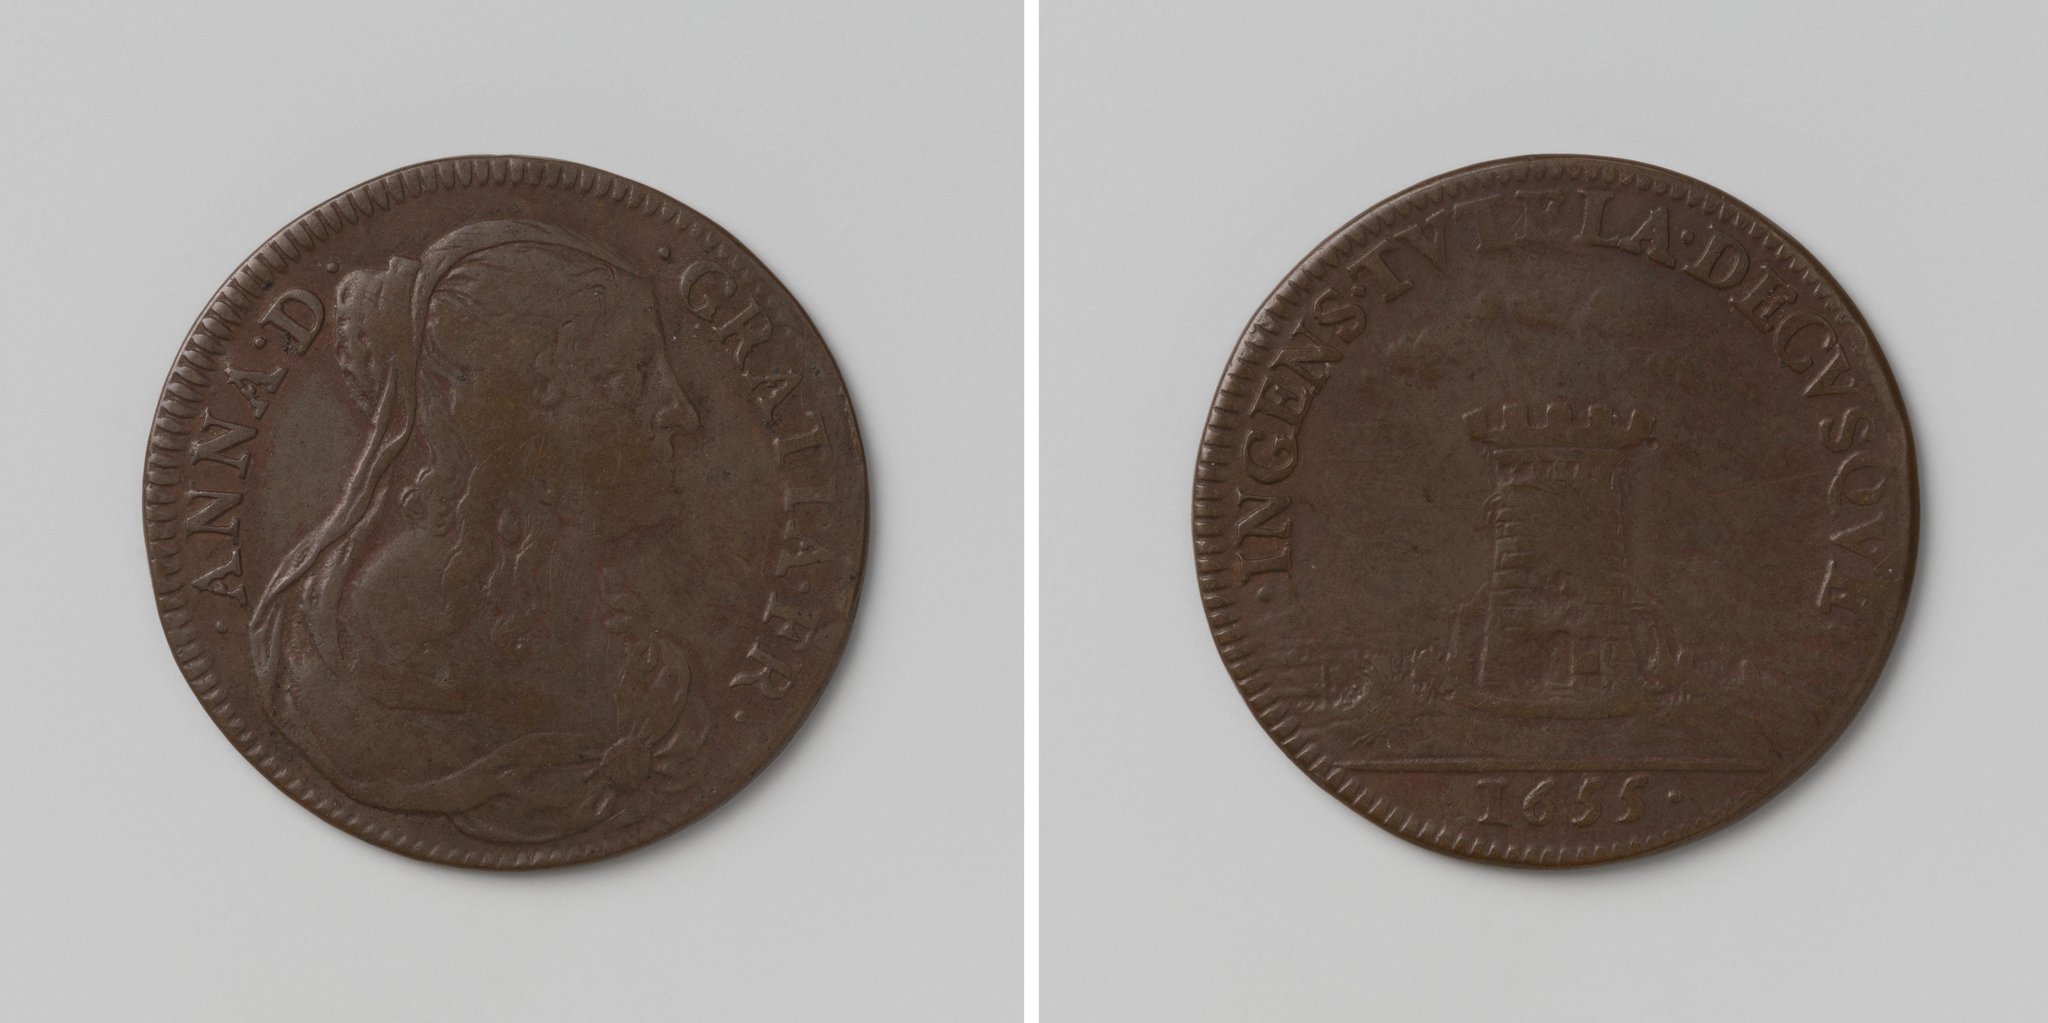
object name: jeton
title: Anna van Oostenrijk, koningin-moeder van Frankrijk, rekenpenning geslagen op last van de stad Doornik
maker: Anonymous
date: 1655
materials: copper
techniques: striking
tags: anna van oostenrijk (koningin van frankrijk)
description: Koperen penning. Voorzijde: borststuk vrouw binnen omschrift. Keerzijde: toren binnen omschrift; afsnede: opschrift